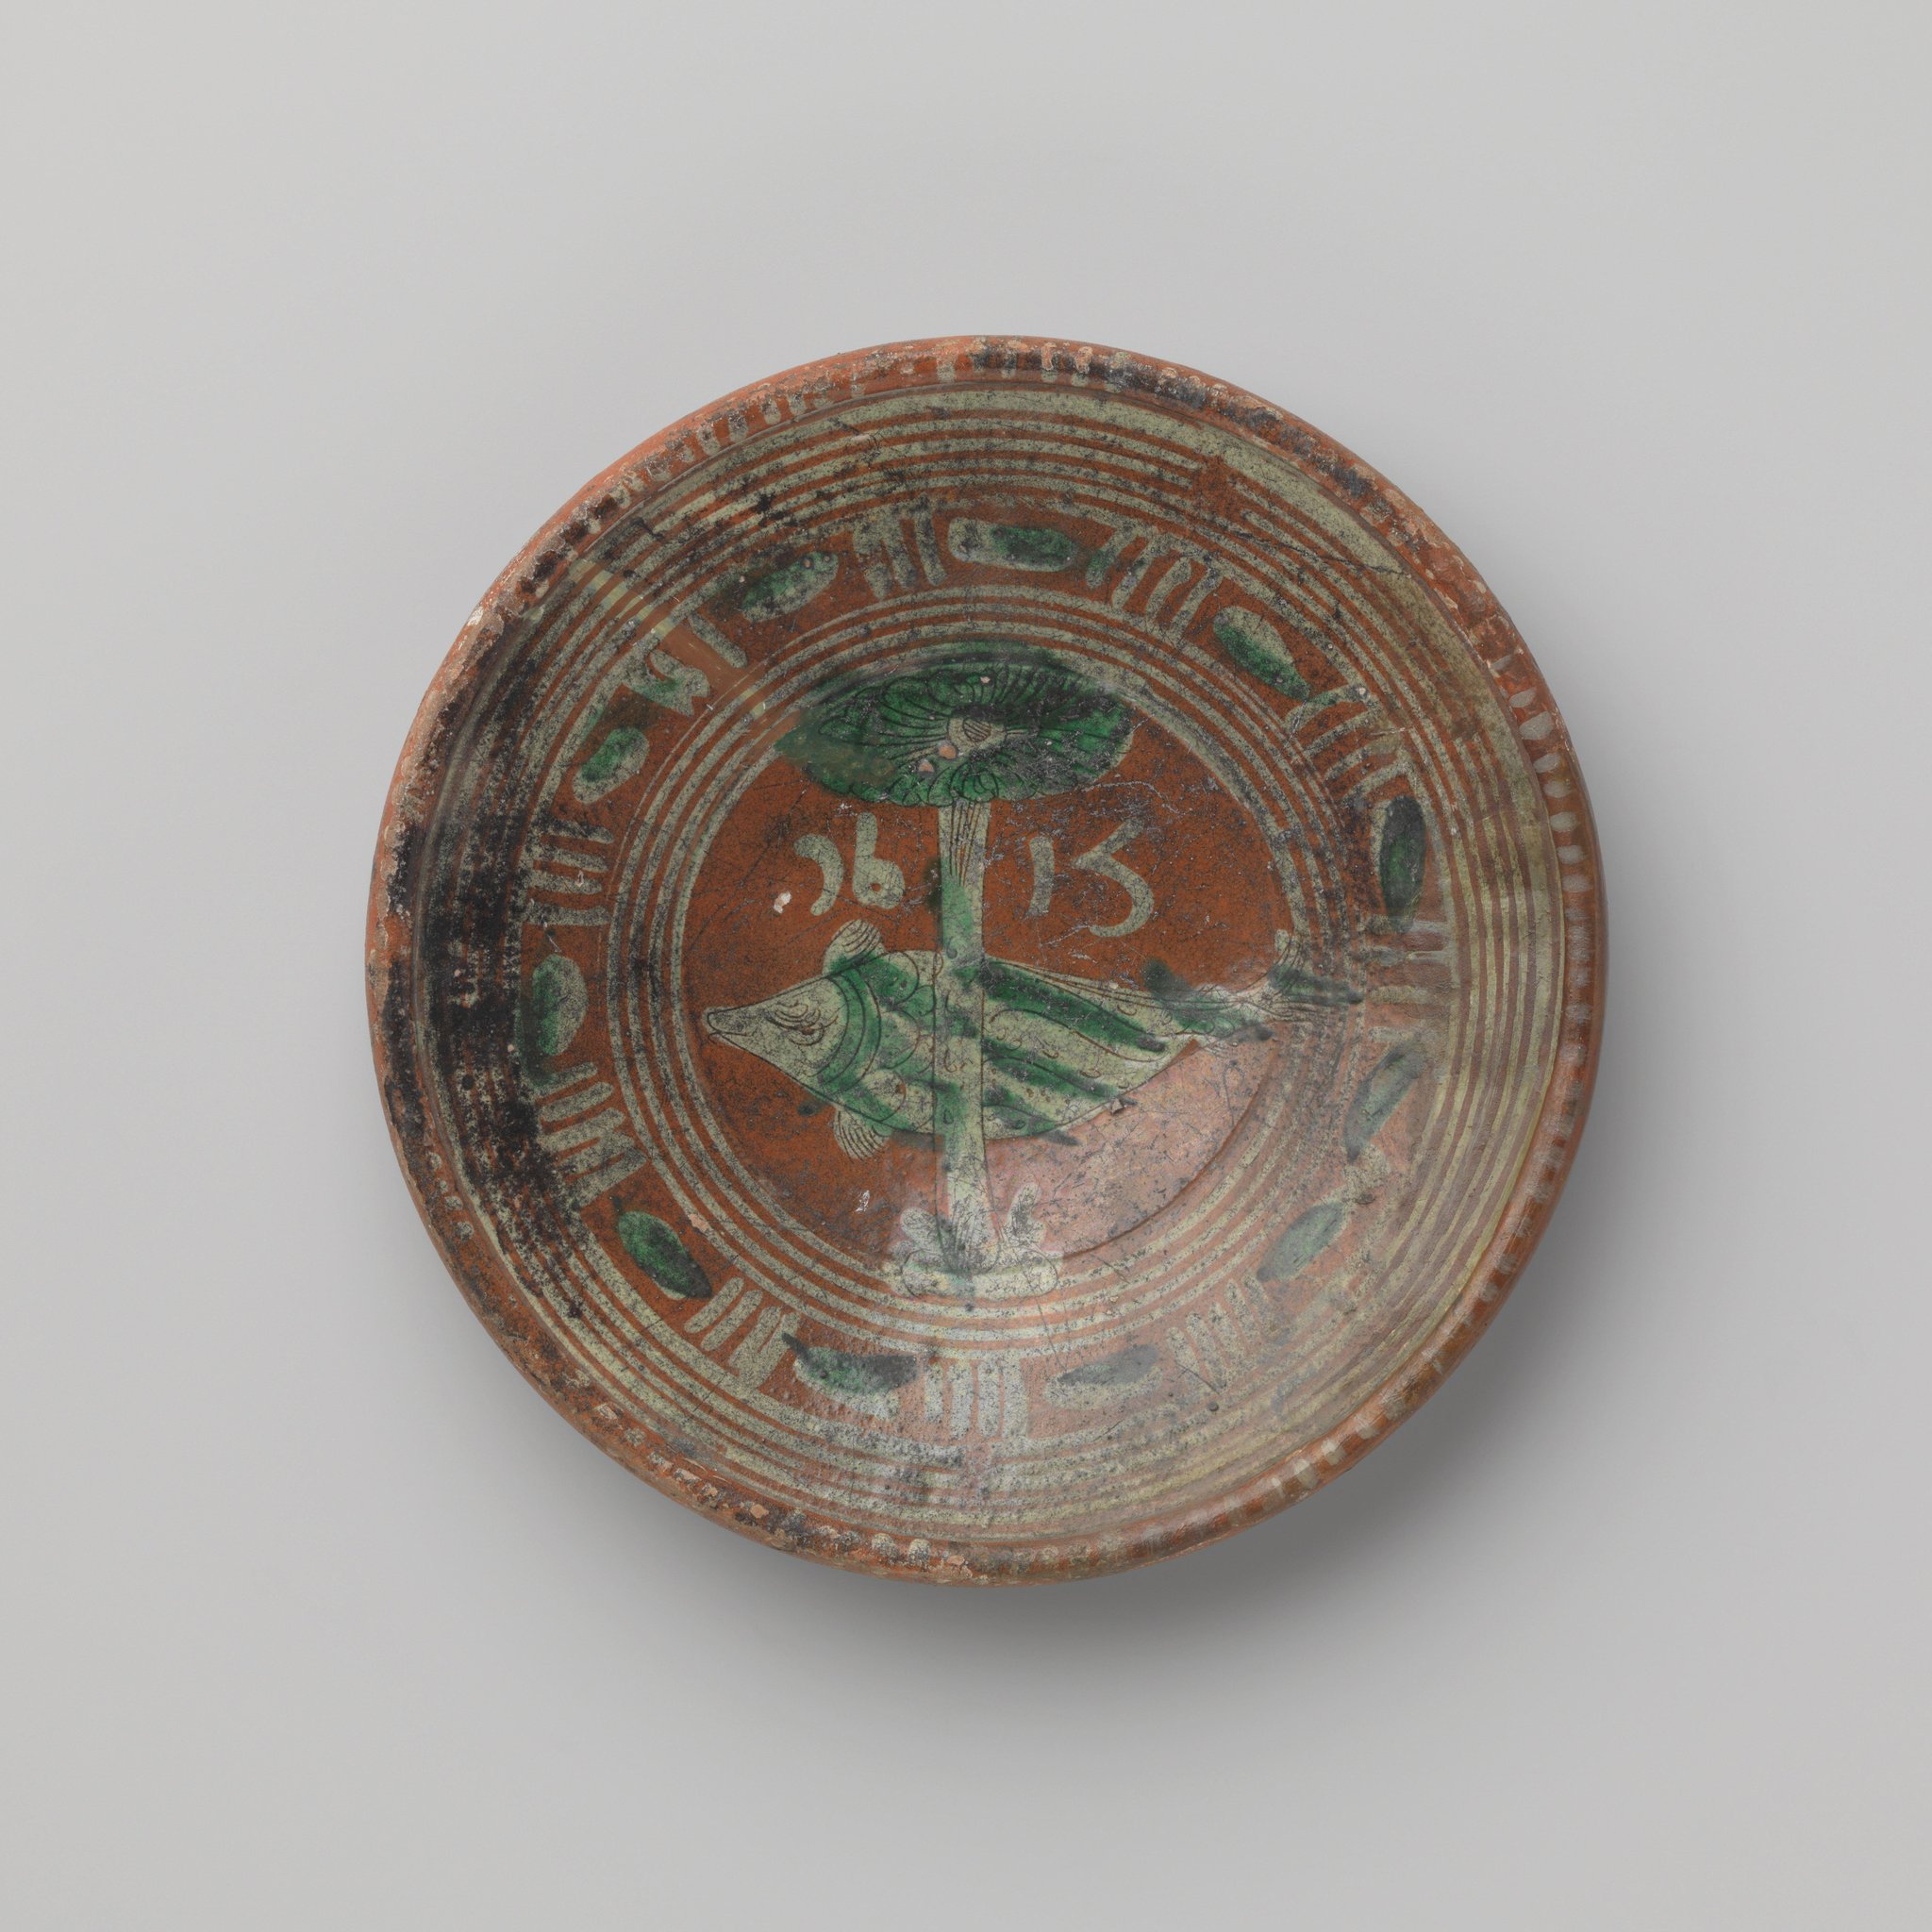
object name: plate dish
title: Bord van loodglazuuraardewerk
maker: Anonymous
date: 1615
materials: earthenware, glaze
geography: germany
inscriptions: date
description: Rond bord van loodglazuuraardewerk. Het plat is in witte slib versierd met een vis, een plant en het jaartal 1615 en de rand met een geometrisch ornament tussen biezen.